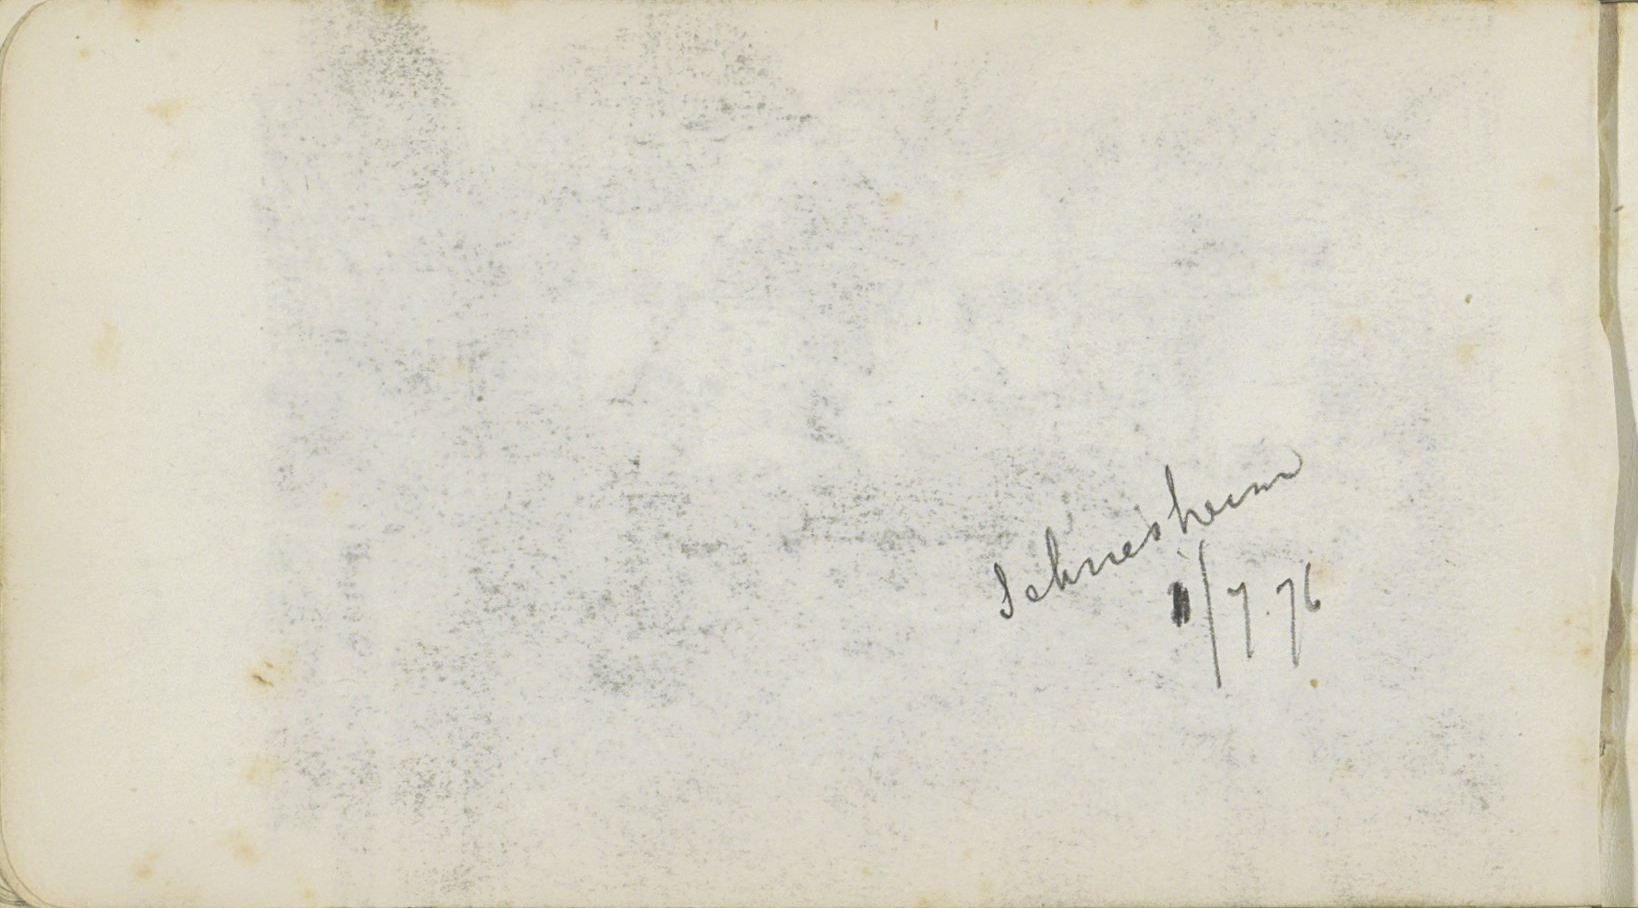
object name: sketchbook leaf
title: Notitie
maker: geo poggenbeek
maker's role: draughtsman, painter, print maker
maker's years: 1853-1903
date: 1807-1876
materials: paper, pencil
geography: schriesheim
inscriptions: date and inscription: ‘Schriesheim/ [...]/7 76’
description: Blad 10 verso uit een schetsboek met 69 bladen.